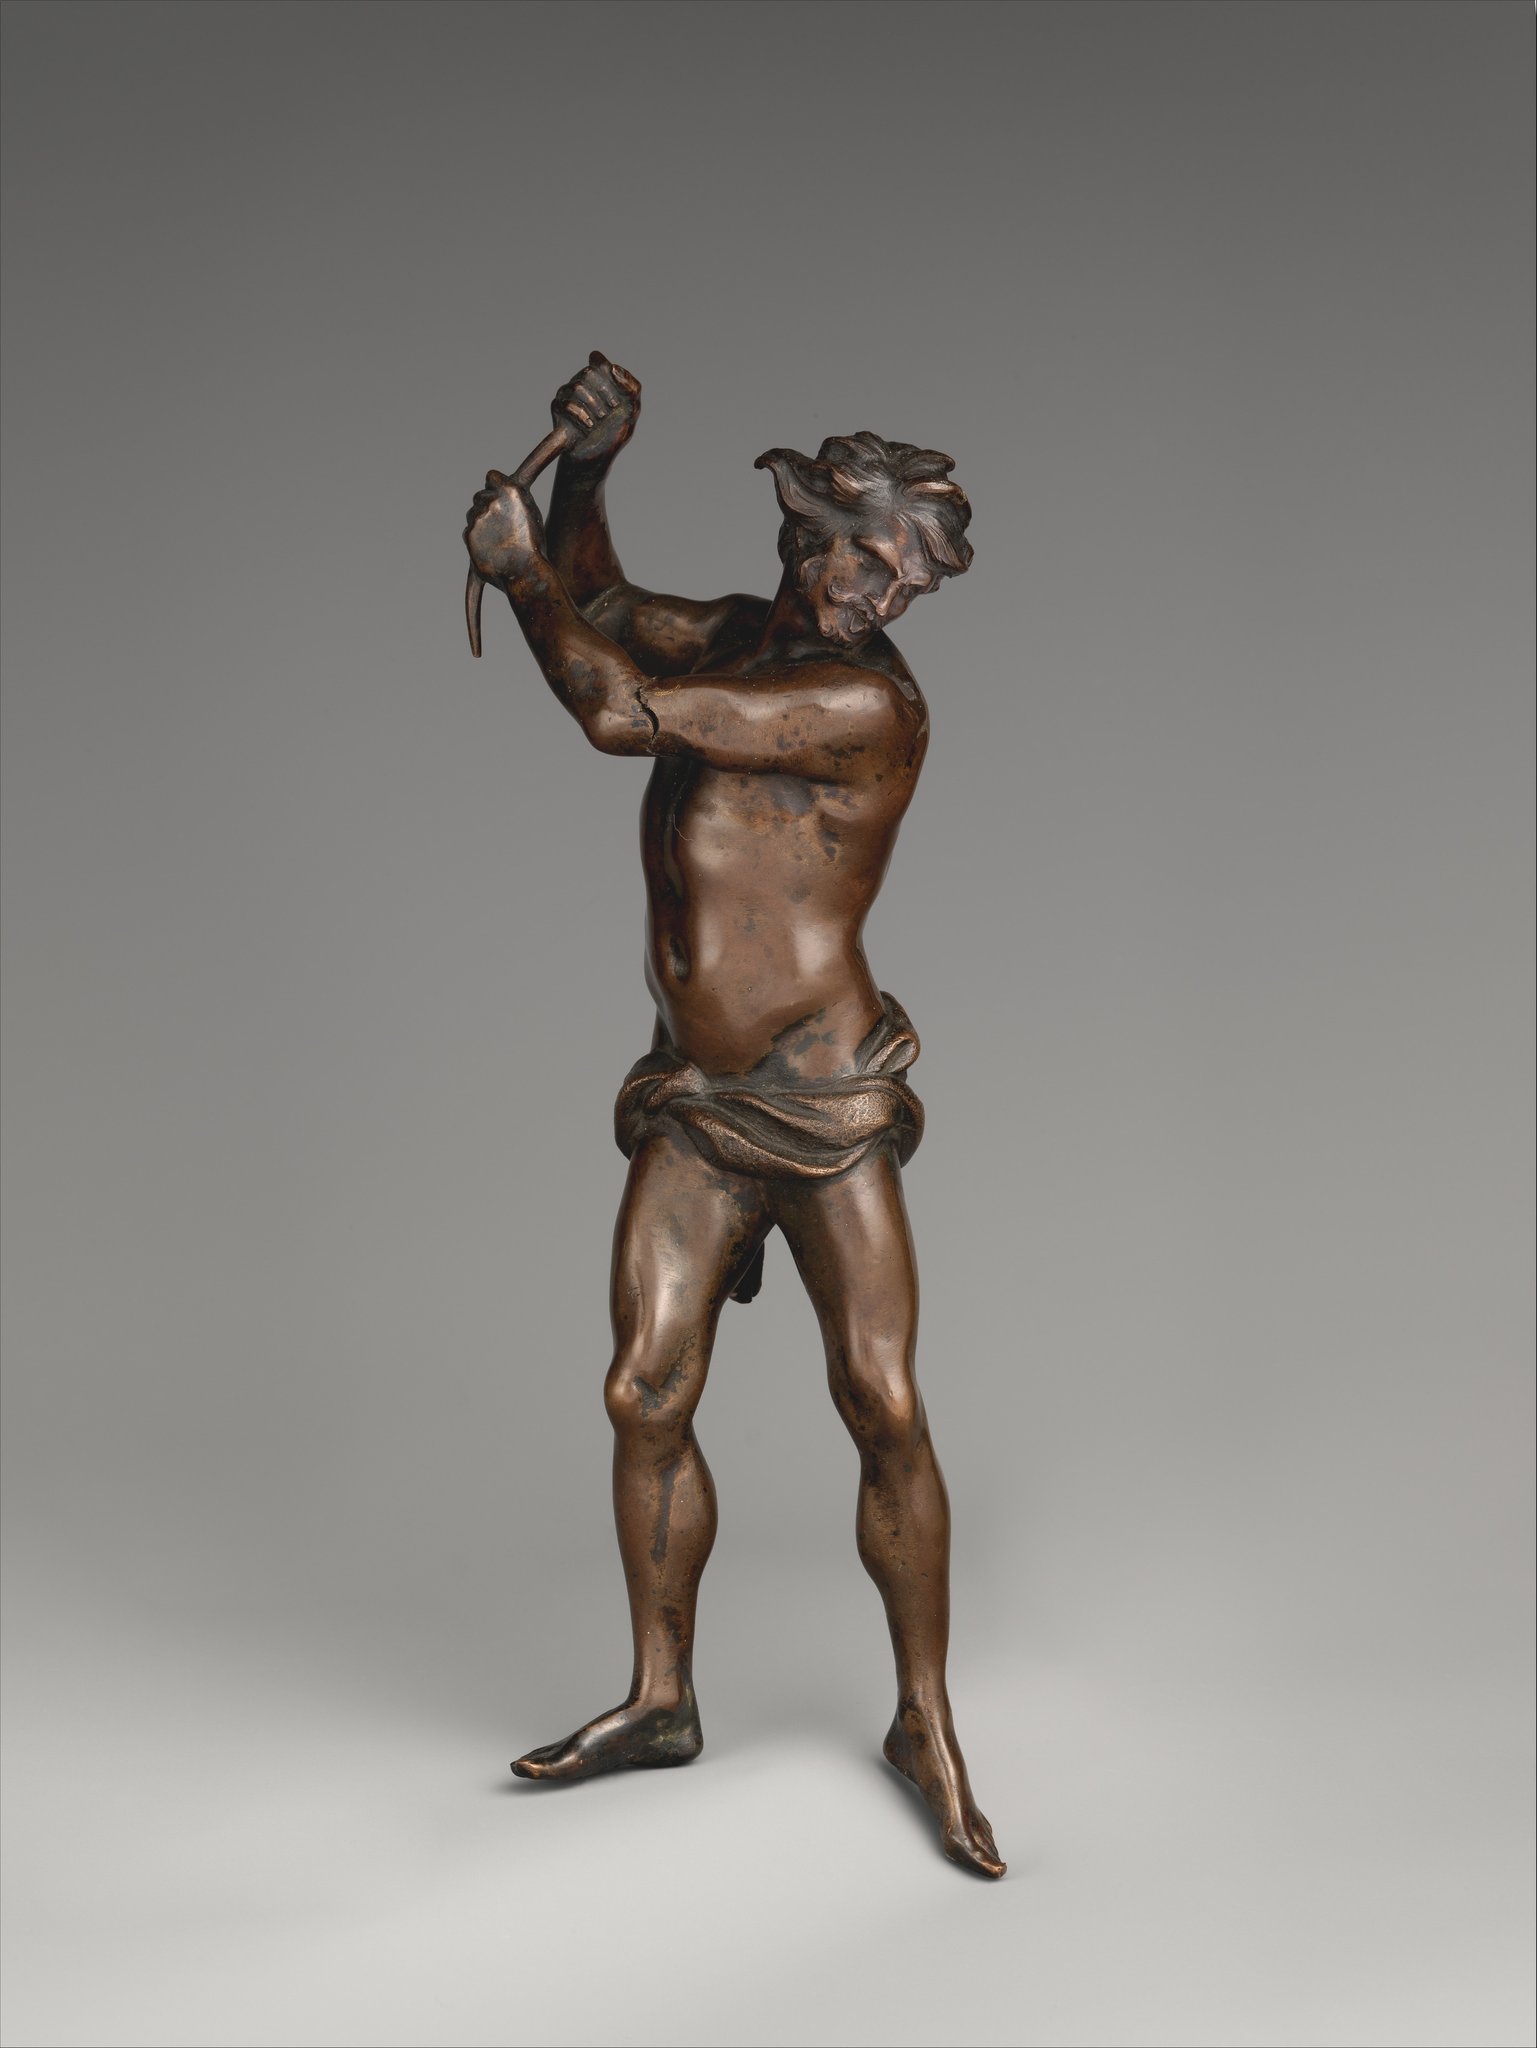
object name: statuette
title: Flagellator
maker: alessandro algardi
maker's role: artist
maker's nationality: italian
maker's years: 1598-1654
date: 1651-1700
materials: bronze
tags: men